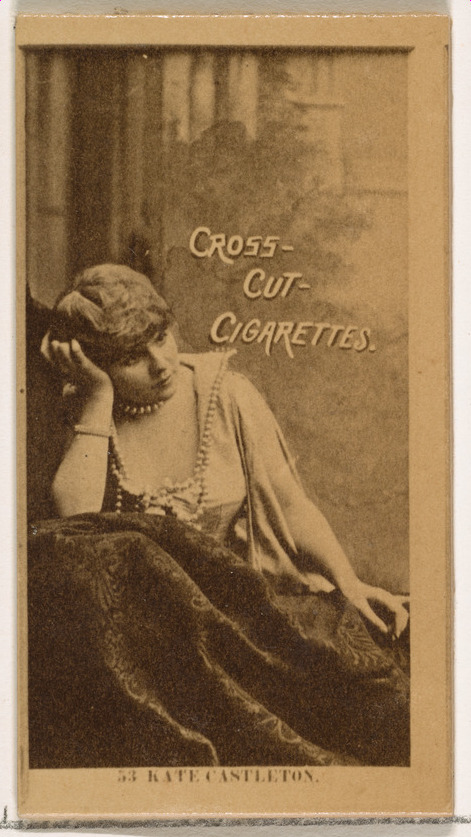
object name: print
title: Card Number 53, Kate Castleton, from the Actors and Actresses series (N145-2) issued by Duke Sons & Co. to promote Cross Cut Cigarettes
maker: w. duke, sons & co.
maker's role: publisher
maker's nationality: american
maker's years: 1870-1920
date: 1880-1889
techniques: albumen silver print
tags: portraits,women,actresses